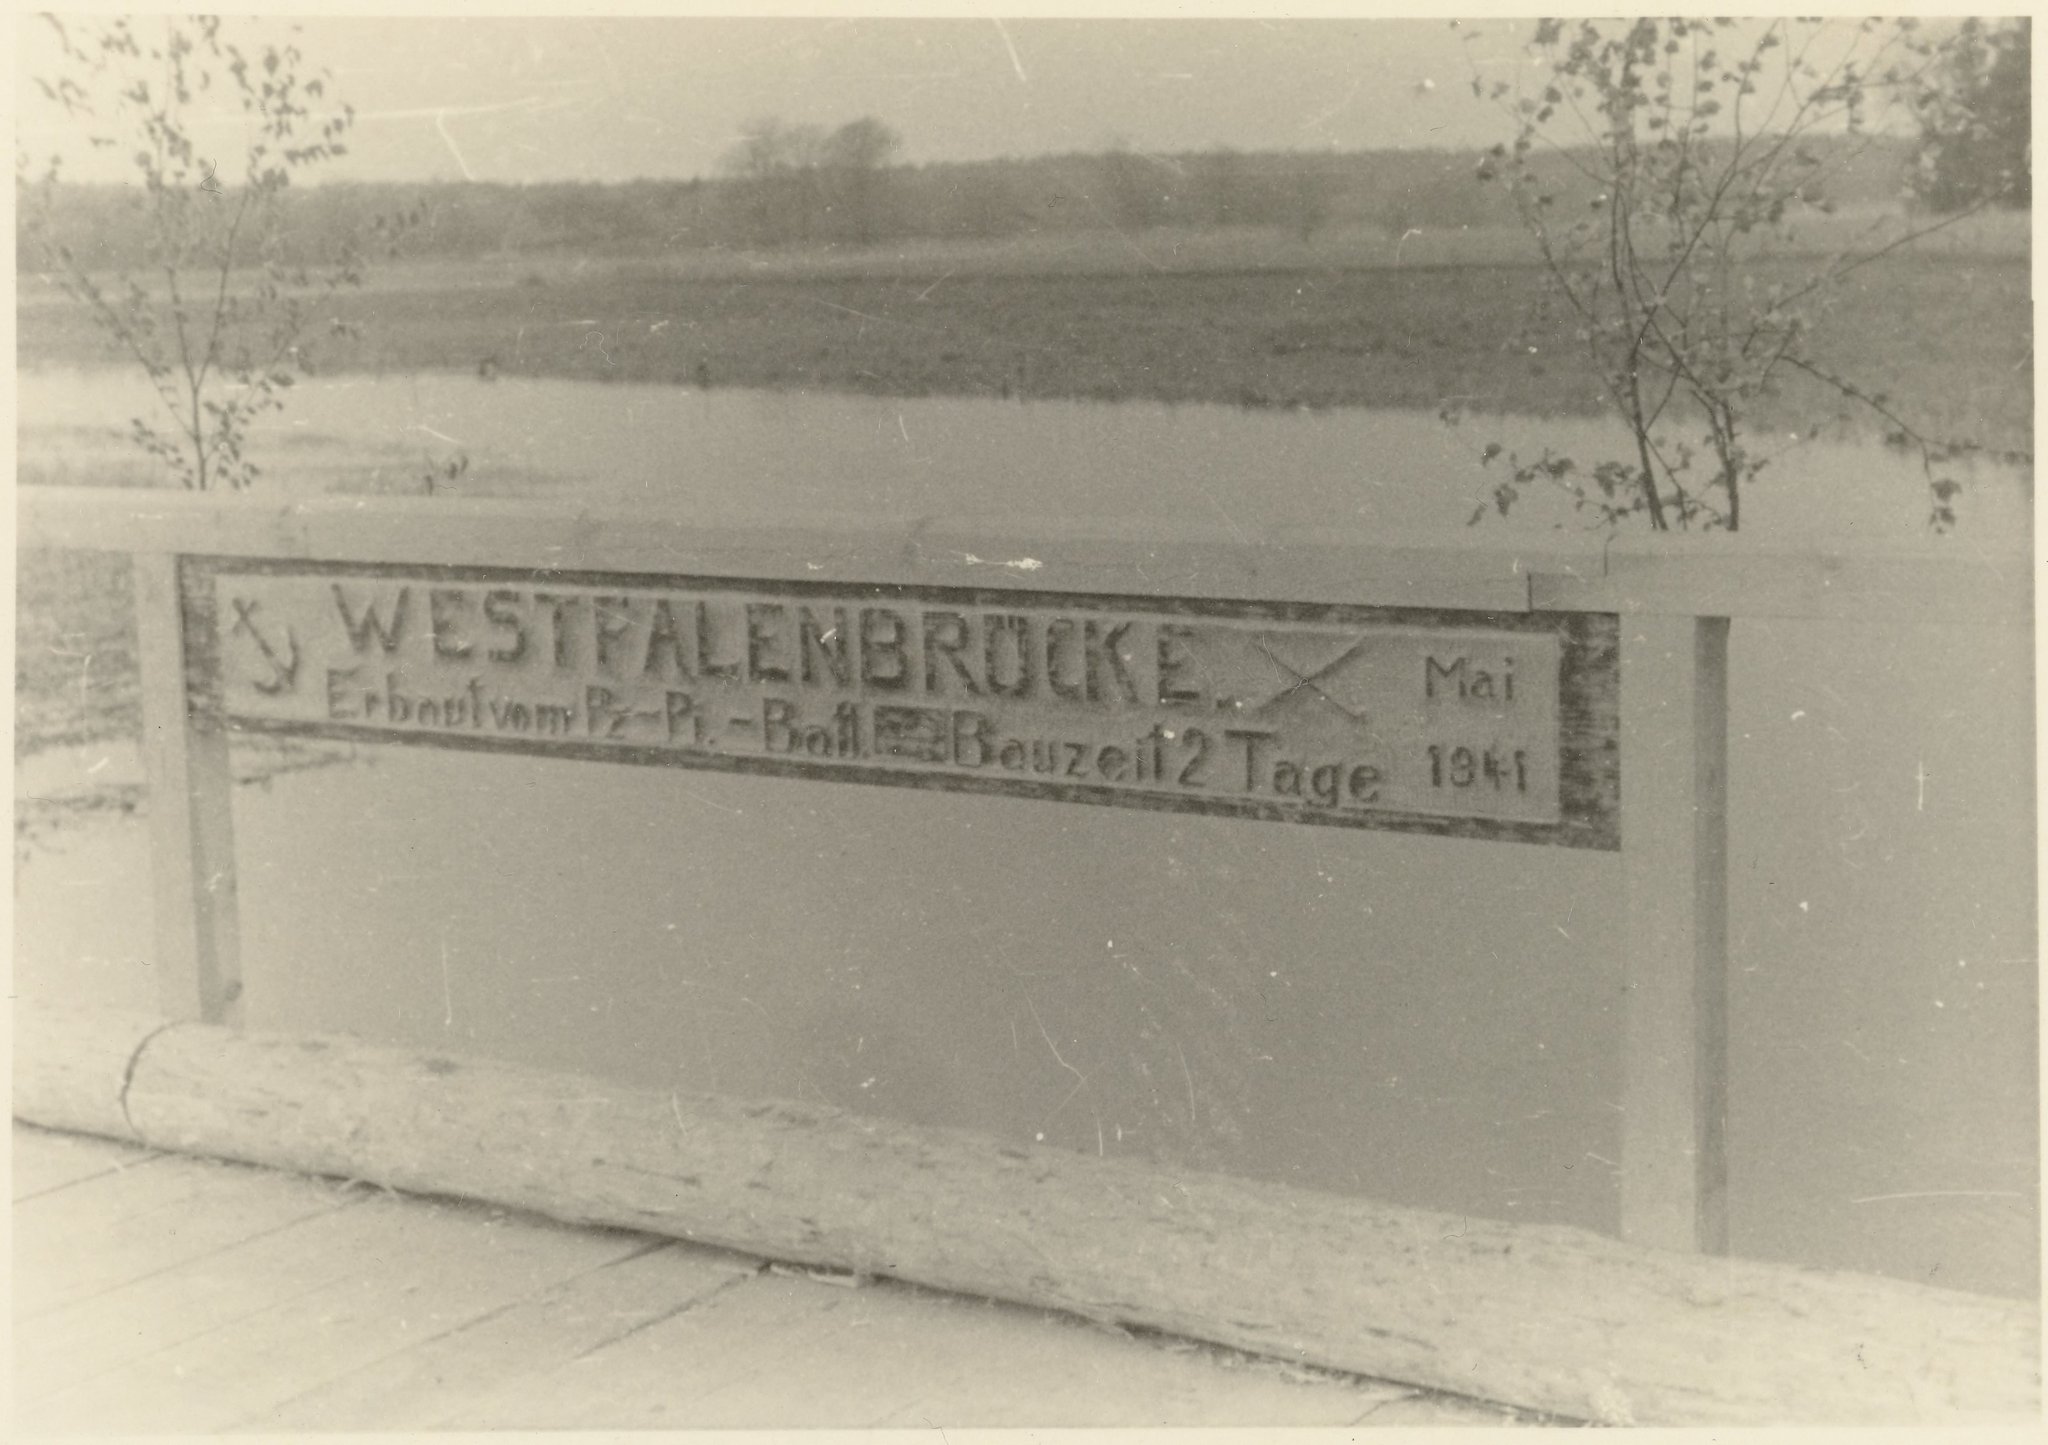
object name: photograph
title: Westfalenbrücke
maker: Anonymous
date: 1940-1945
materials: photographic support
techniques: gelatin silver print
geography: czechoslovakia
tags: netherlands, germany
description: Een houten brug met een bord met de tekst dat deze brug in twee dagen gebouwd is, Westfalenbrücke. Foto behorend bij album 'Kriegserinnerungen'.